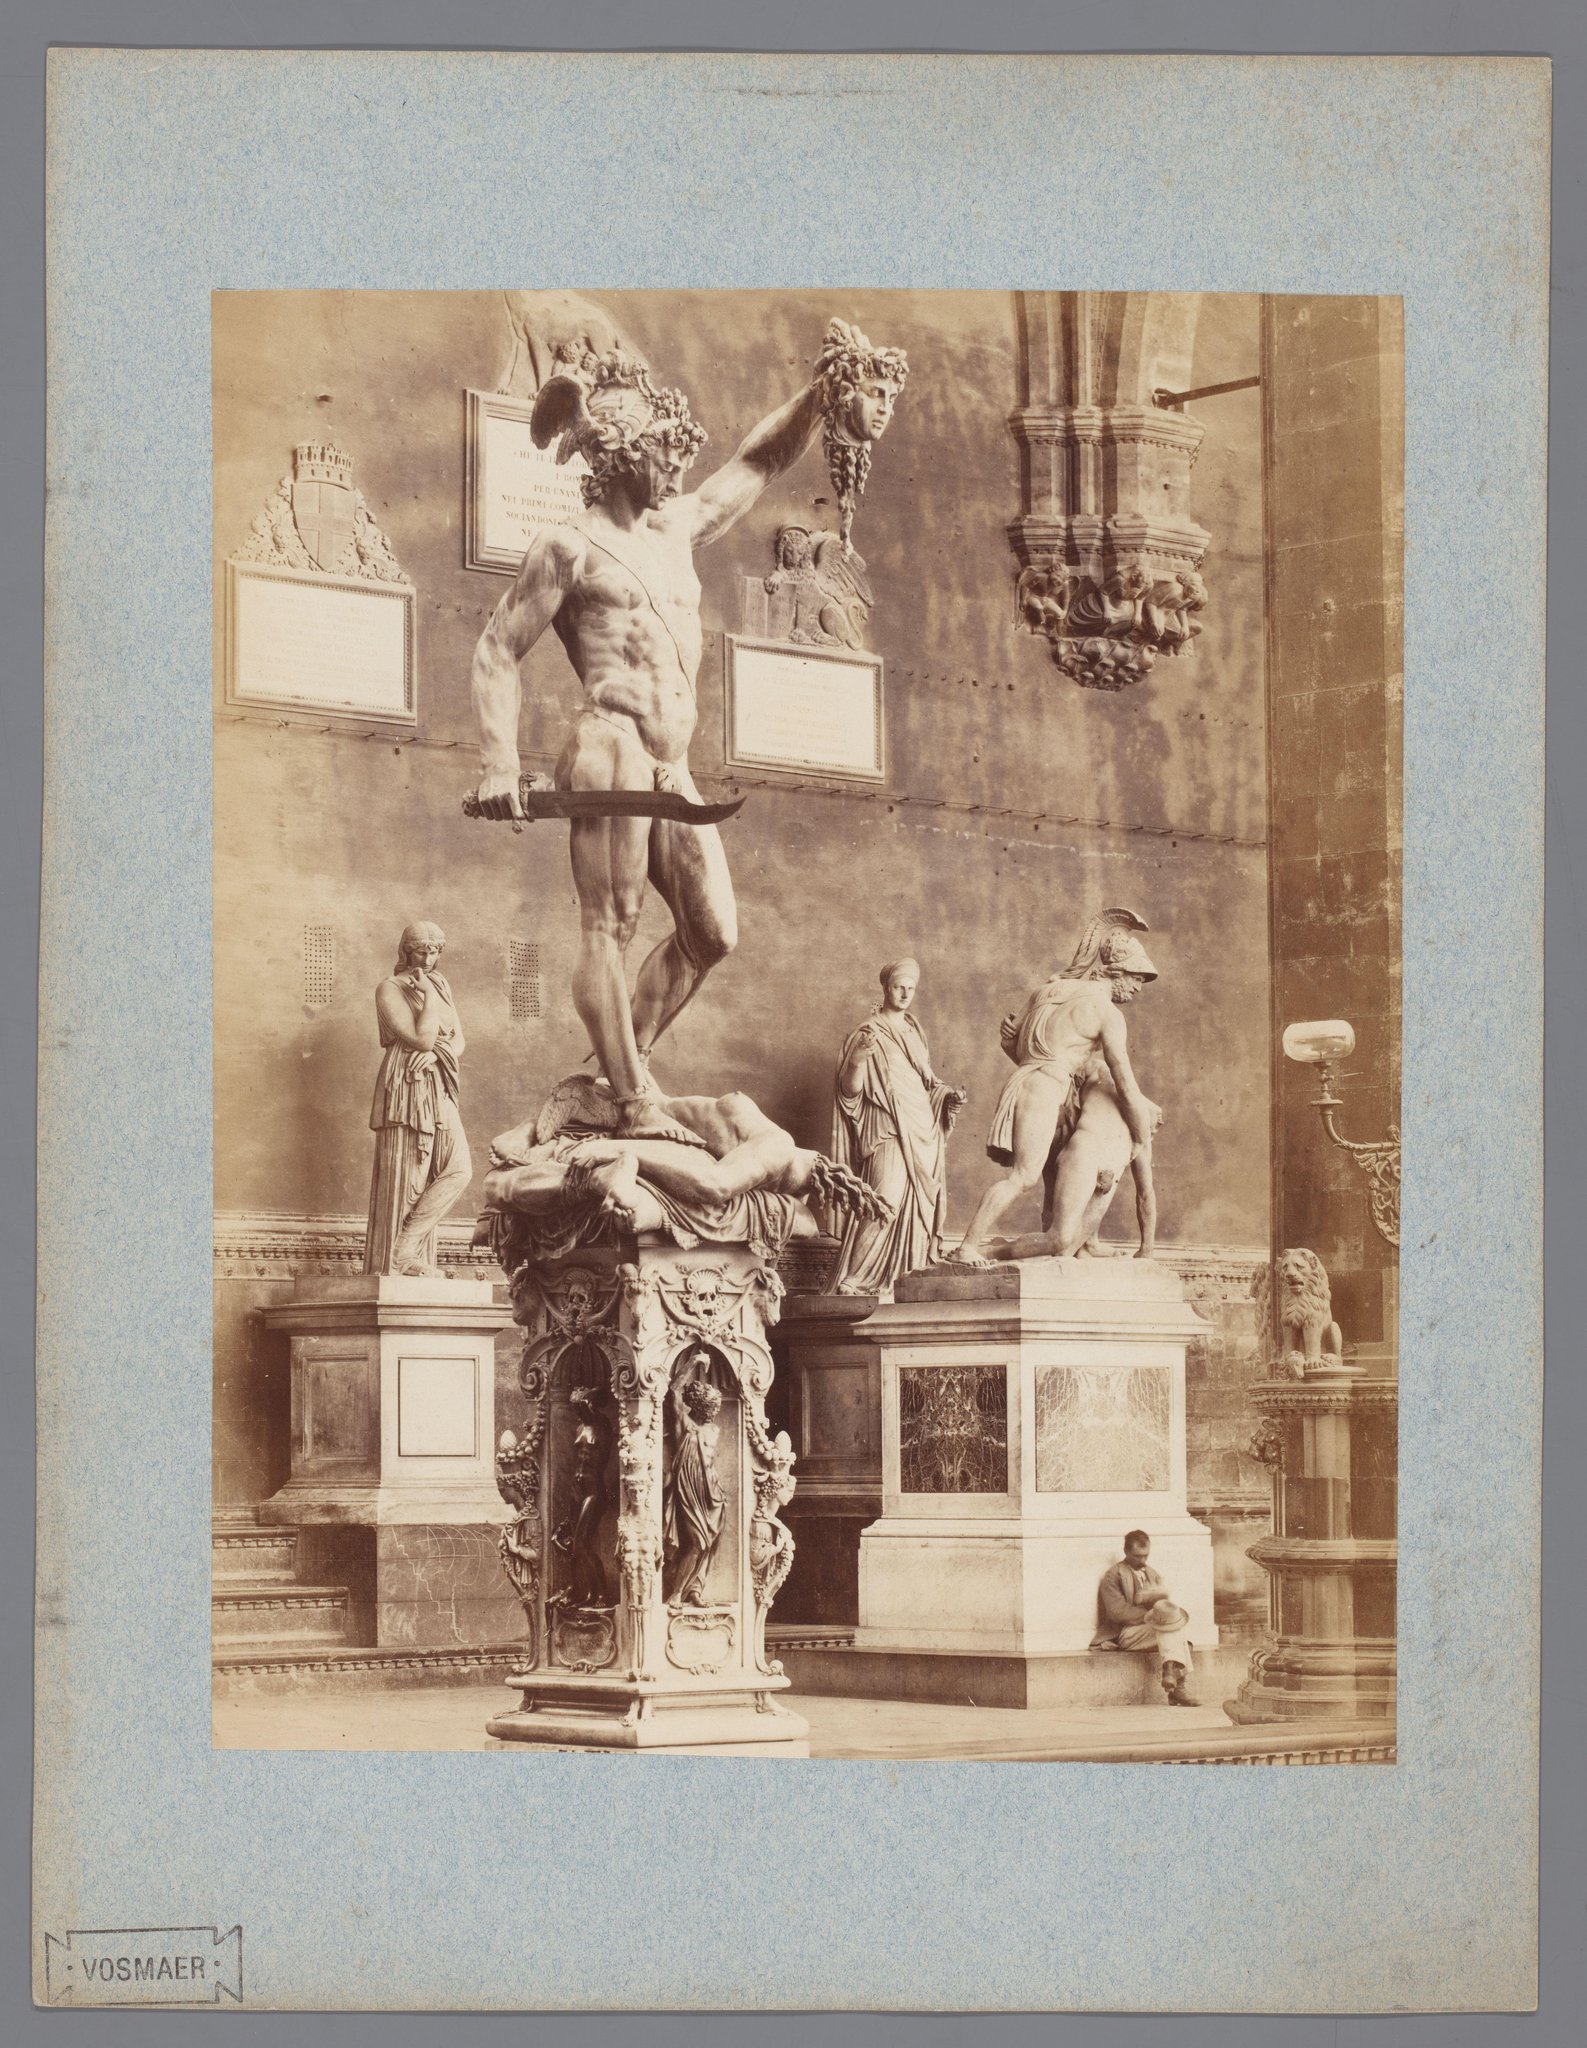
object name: photograph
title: Sculptuur van Perseus met het hoofd van Medusa door Benvenuto Cellini in de Loggia dei Lanzi te Florence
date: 1851-1900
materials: cardboard, paper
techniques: albumen print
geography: florence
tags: gallery of sculptures, piece of sculpture, reproduction of a piece of sculpture, (story of) perseus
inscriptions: inscription: ‘Firenze/ Perseus di Bevenuto/ Cellini’, collector's mark: ‘VOSMAER’